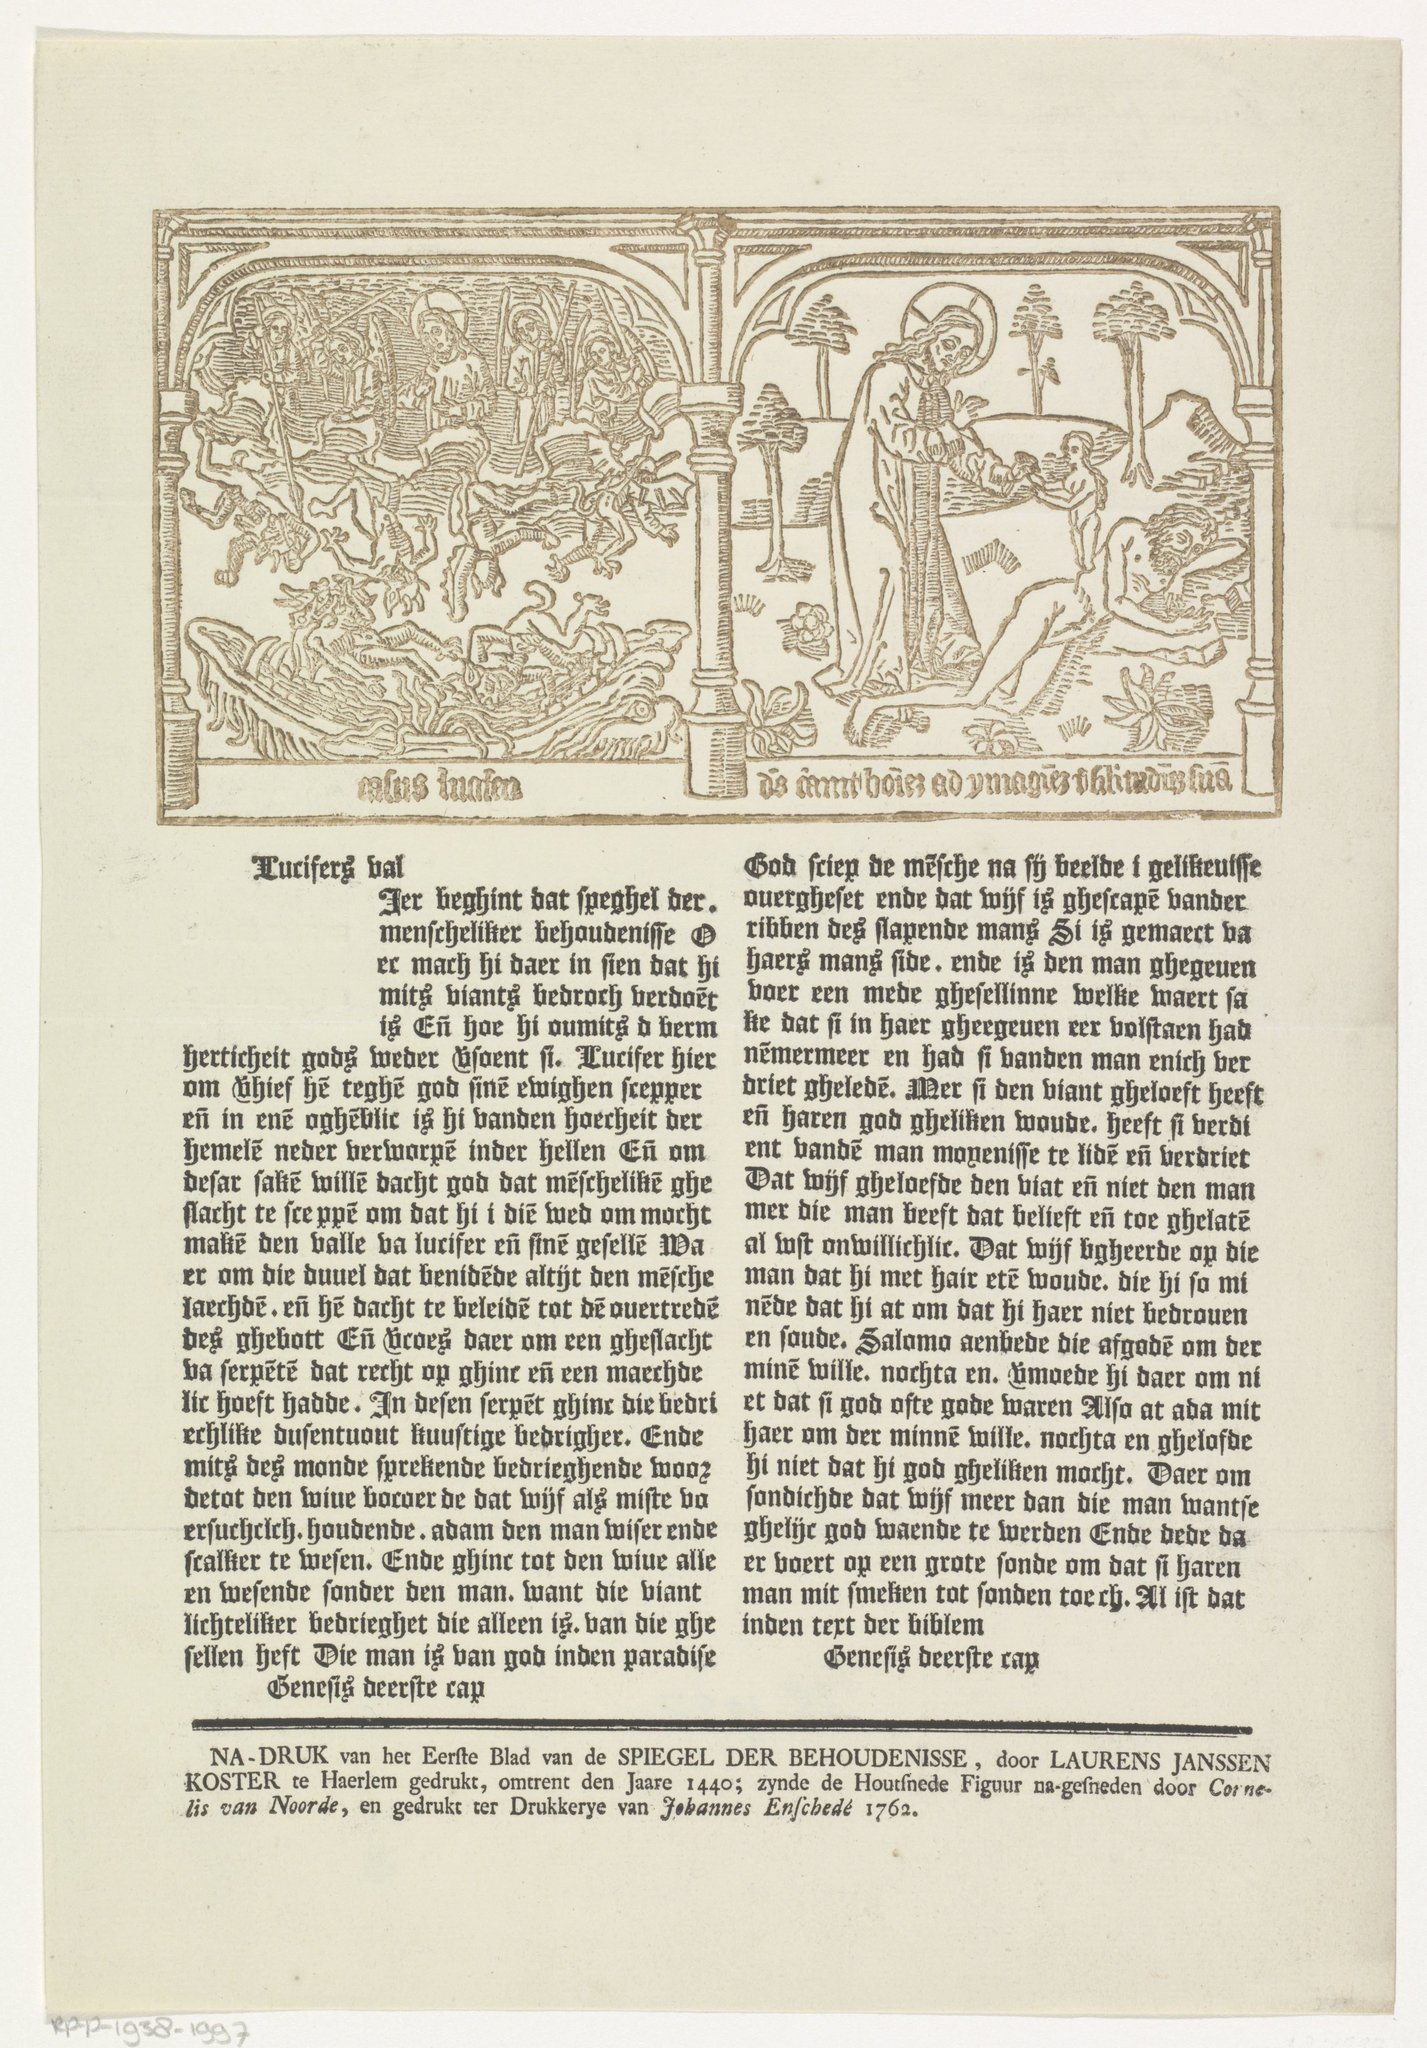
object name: print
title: Val van Lucifer (Satan) en de schepping van Eva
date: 1762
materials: paper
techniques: letterpress printing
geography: haarlem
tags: the fall of satan, fall of lucifer, creation of eve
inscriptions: collector's mark: Lugt 2760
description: Links de val van Lucifer (Satan) en rechts de schepping van Eva uit een rib van Adam. In een kader twee regels Latijnse tekst. Eronder twee kolommen met Nederlandse tekst.